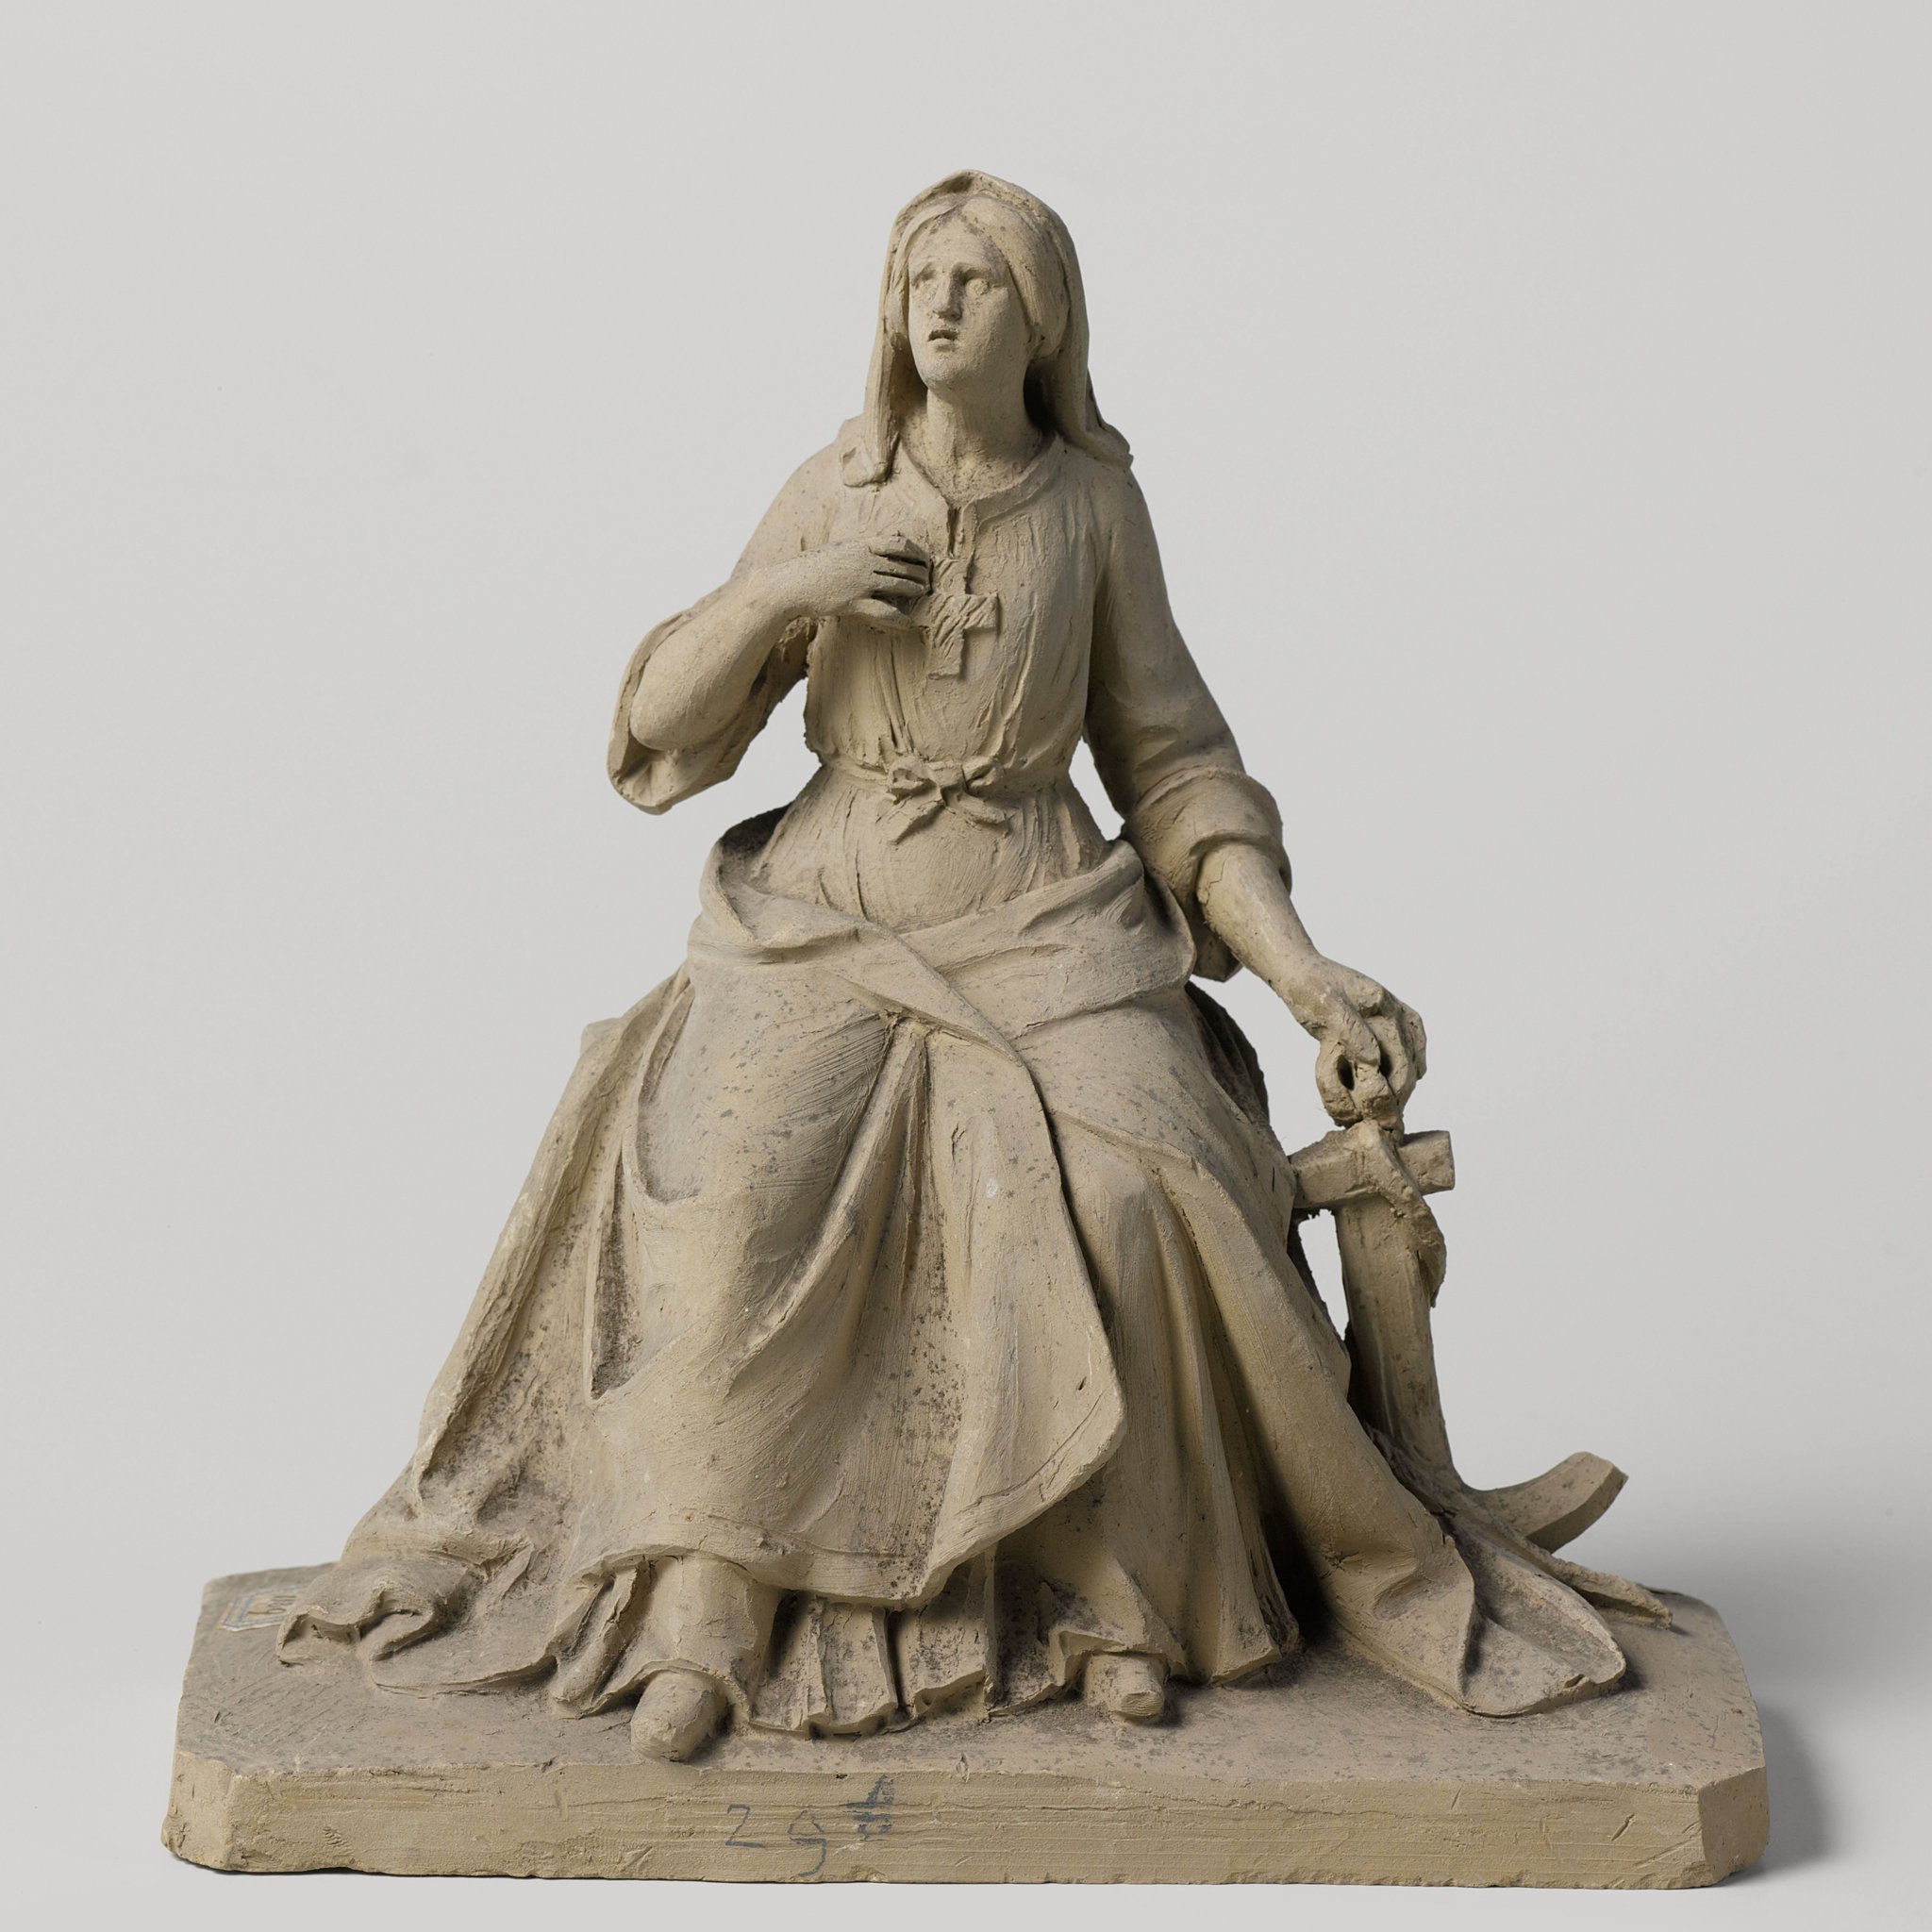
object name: sculpture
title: De Hoop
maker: eugène lacomblé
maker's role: draughtsman, painter, sculptor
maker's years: 1828-1905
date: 1800-1900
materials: clay